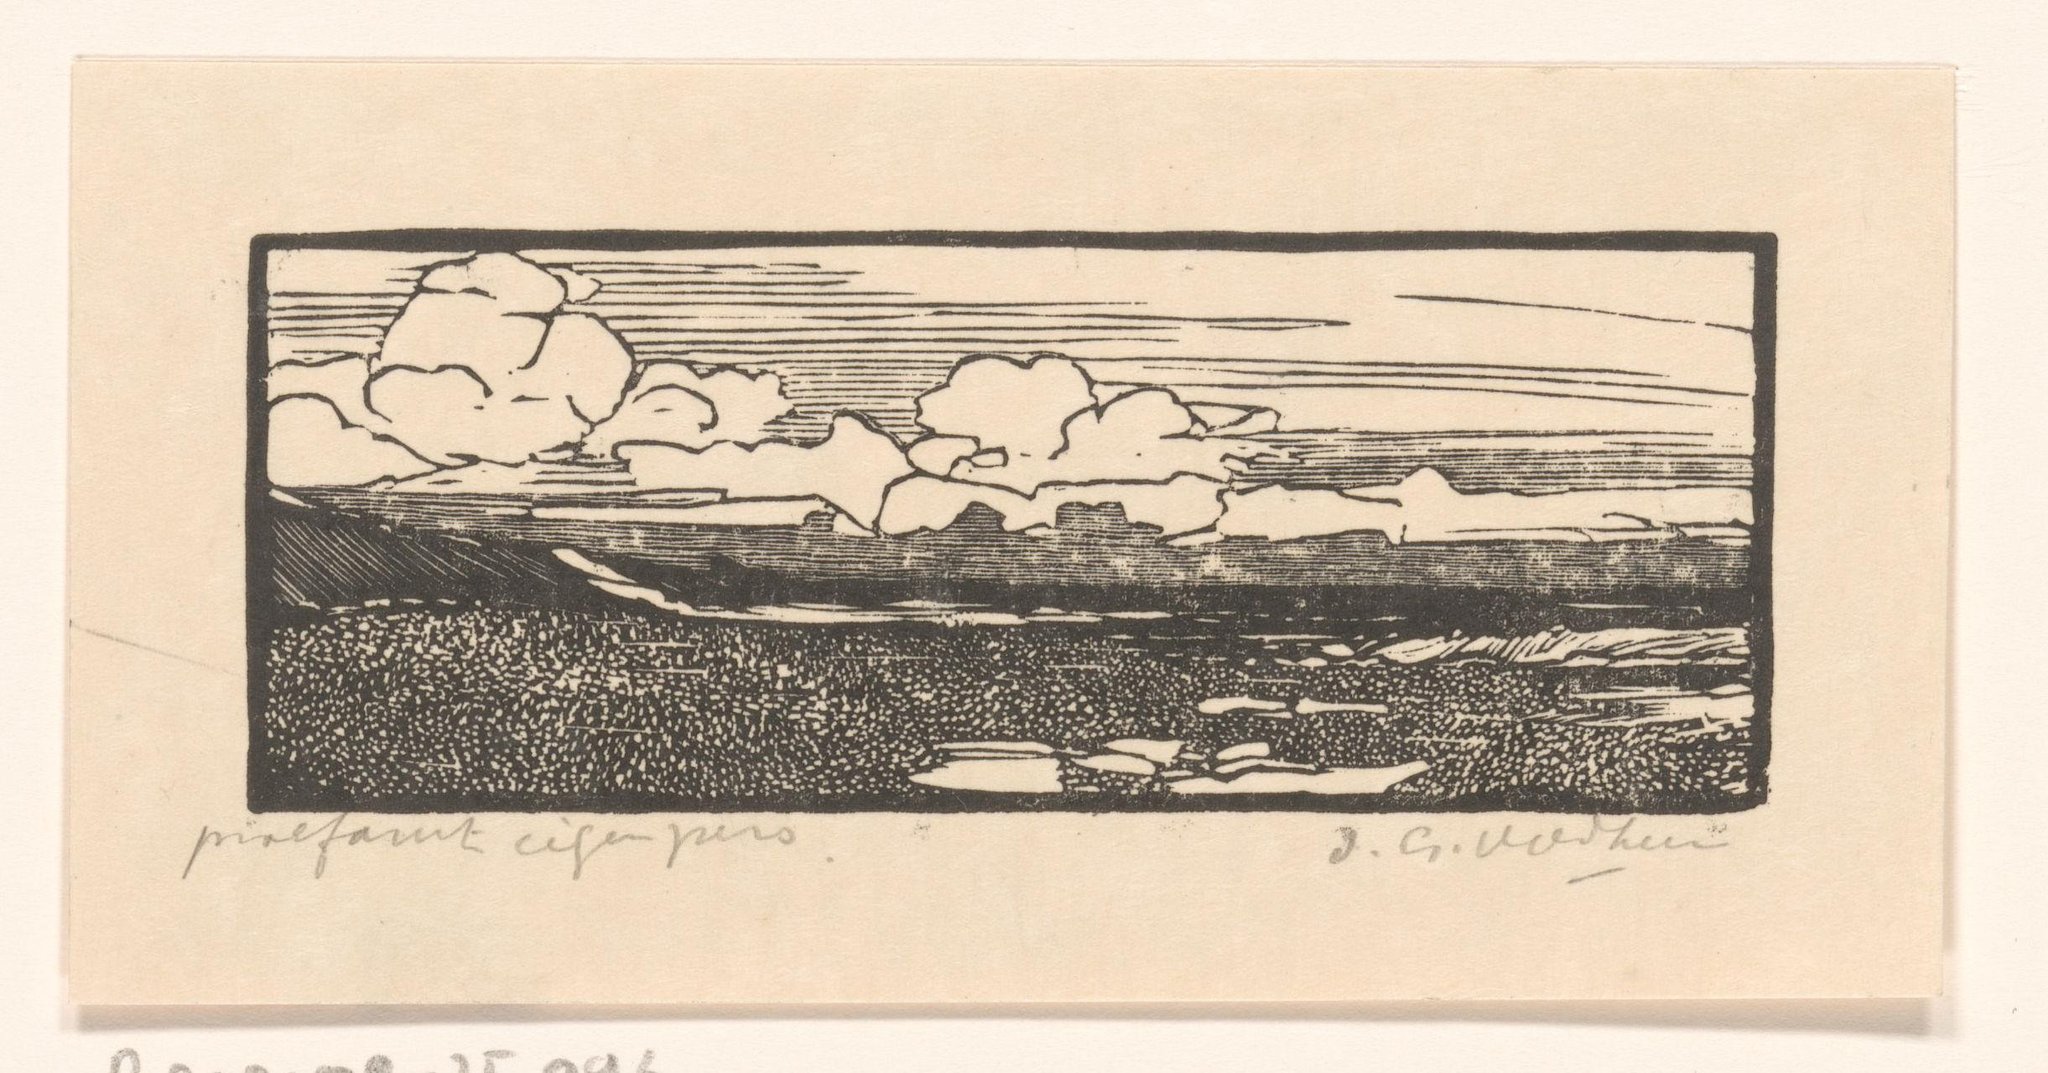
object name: print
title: Duinen bij Bergen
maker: jacobus gerardus veldheer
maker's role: draughtsman, print maker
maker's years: 1866-1954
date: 1876-1954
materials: paper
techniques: woodcut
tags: dune coast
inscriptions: collector's mark: Lugt 2228